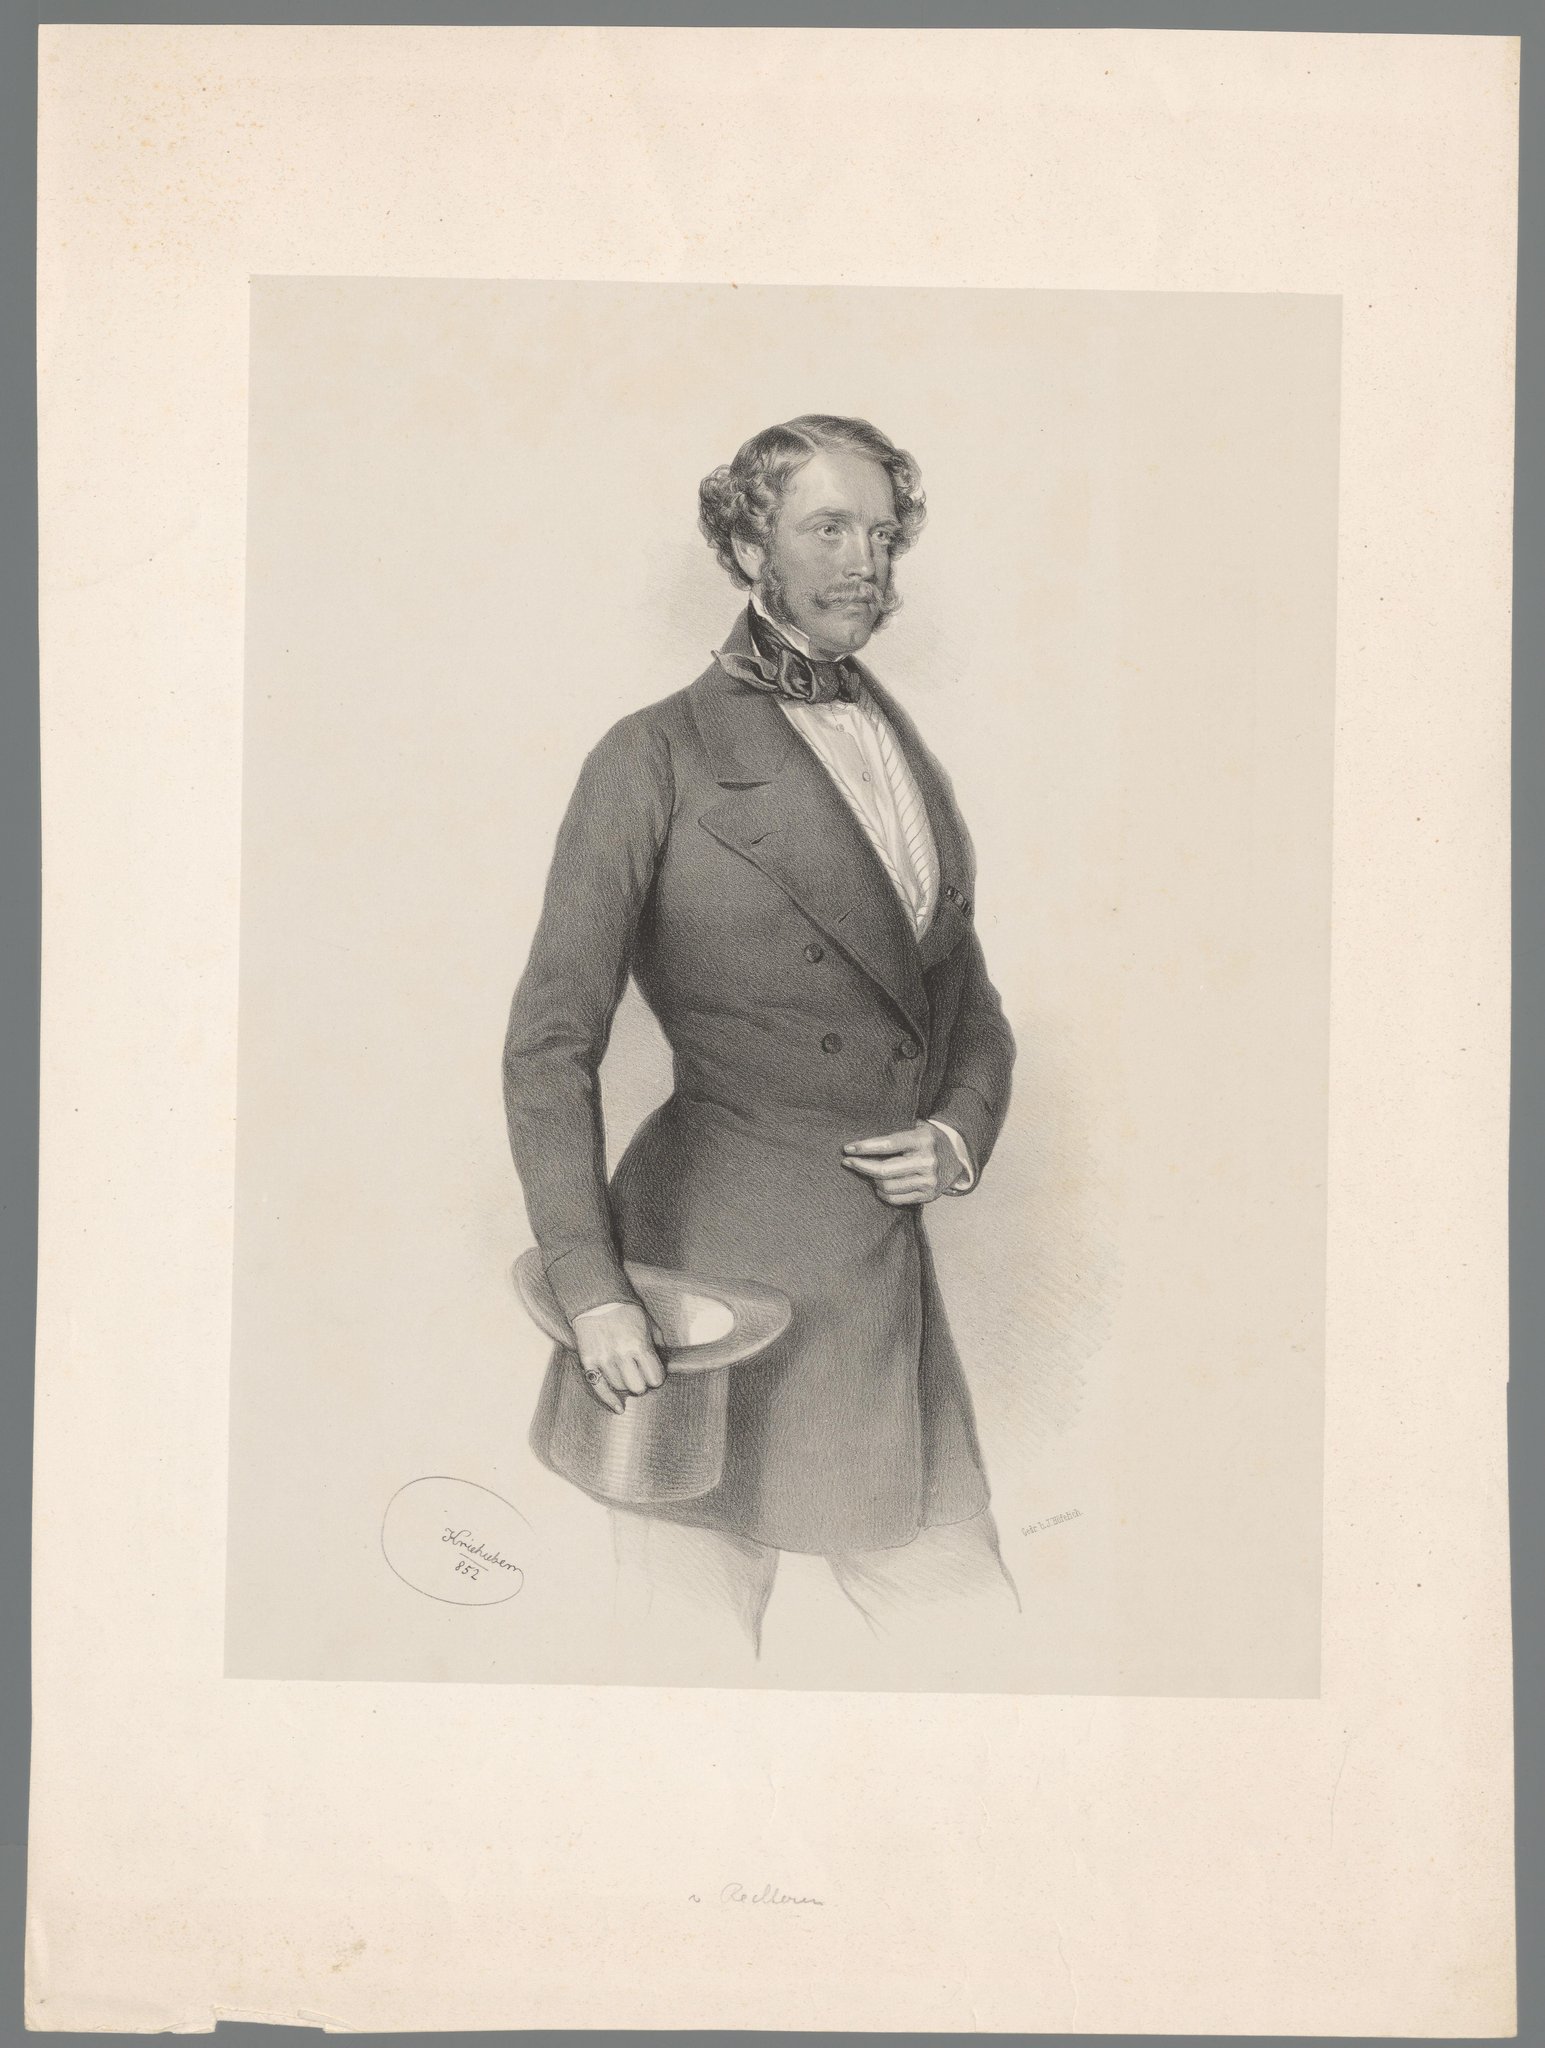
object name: print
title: Portret van Johan Derck graaf van Rechteren van Ahnem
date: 1852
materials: paper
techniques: lithograph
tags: historical persons, politician, e.g. party leader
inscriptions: collector's mark: Lugt 2228